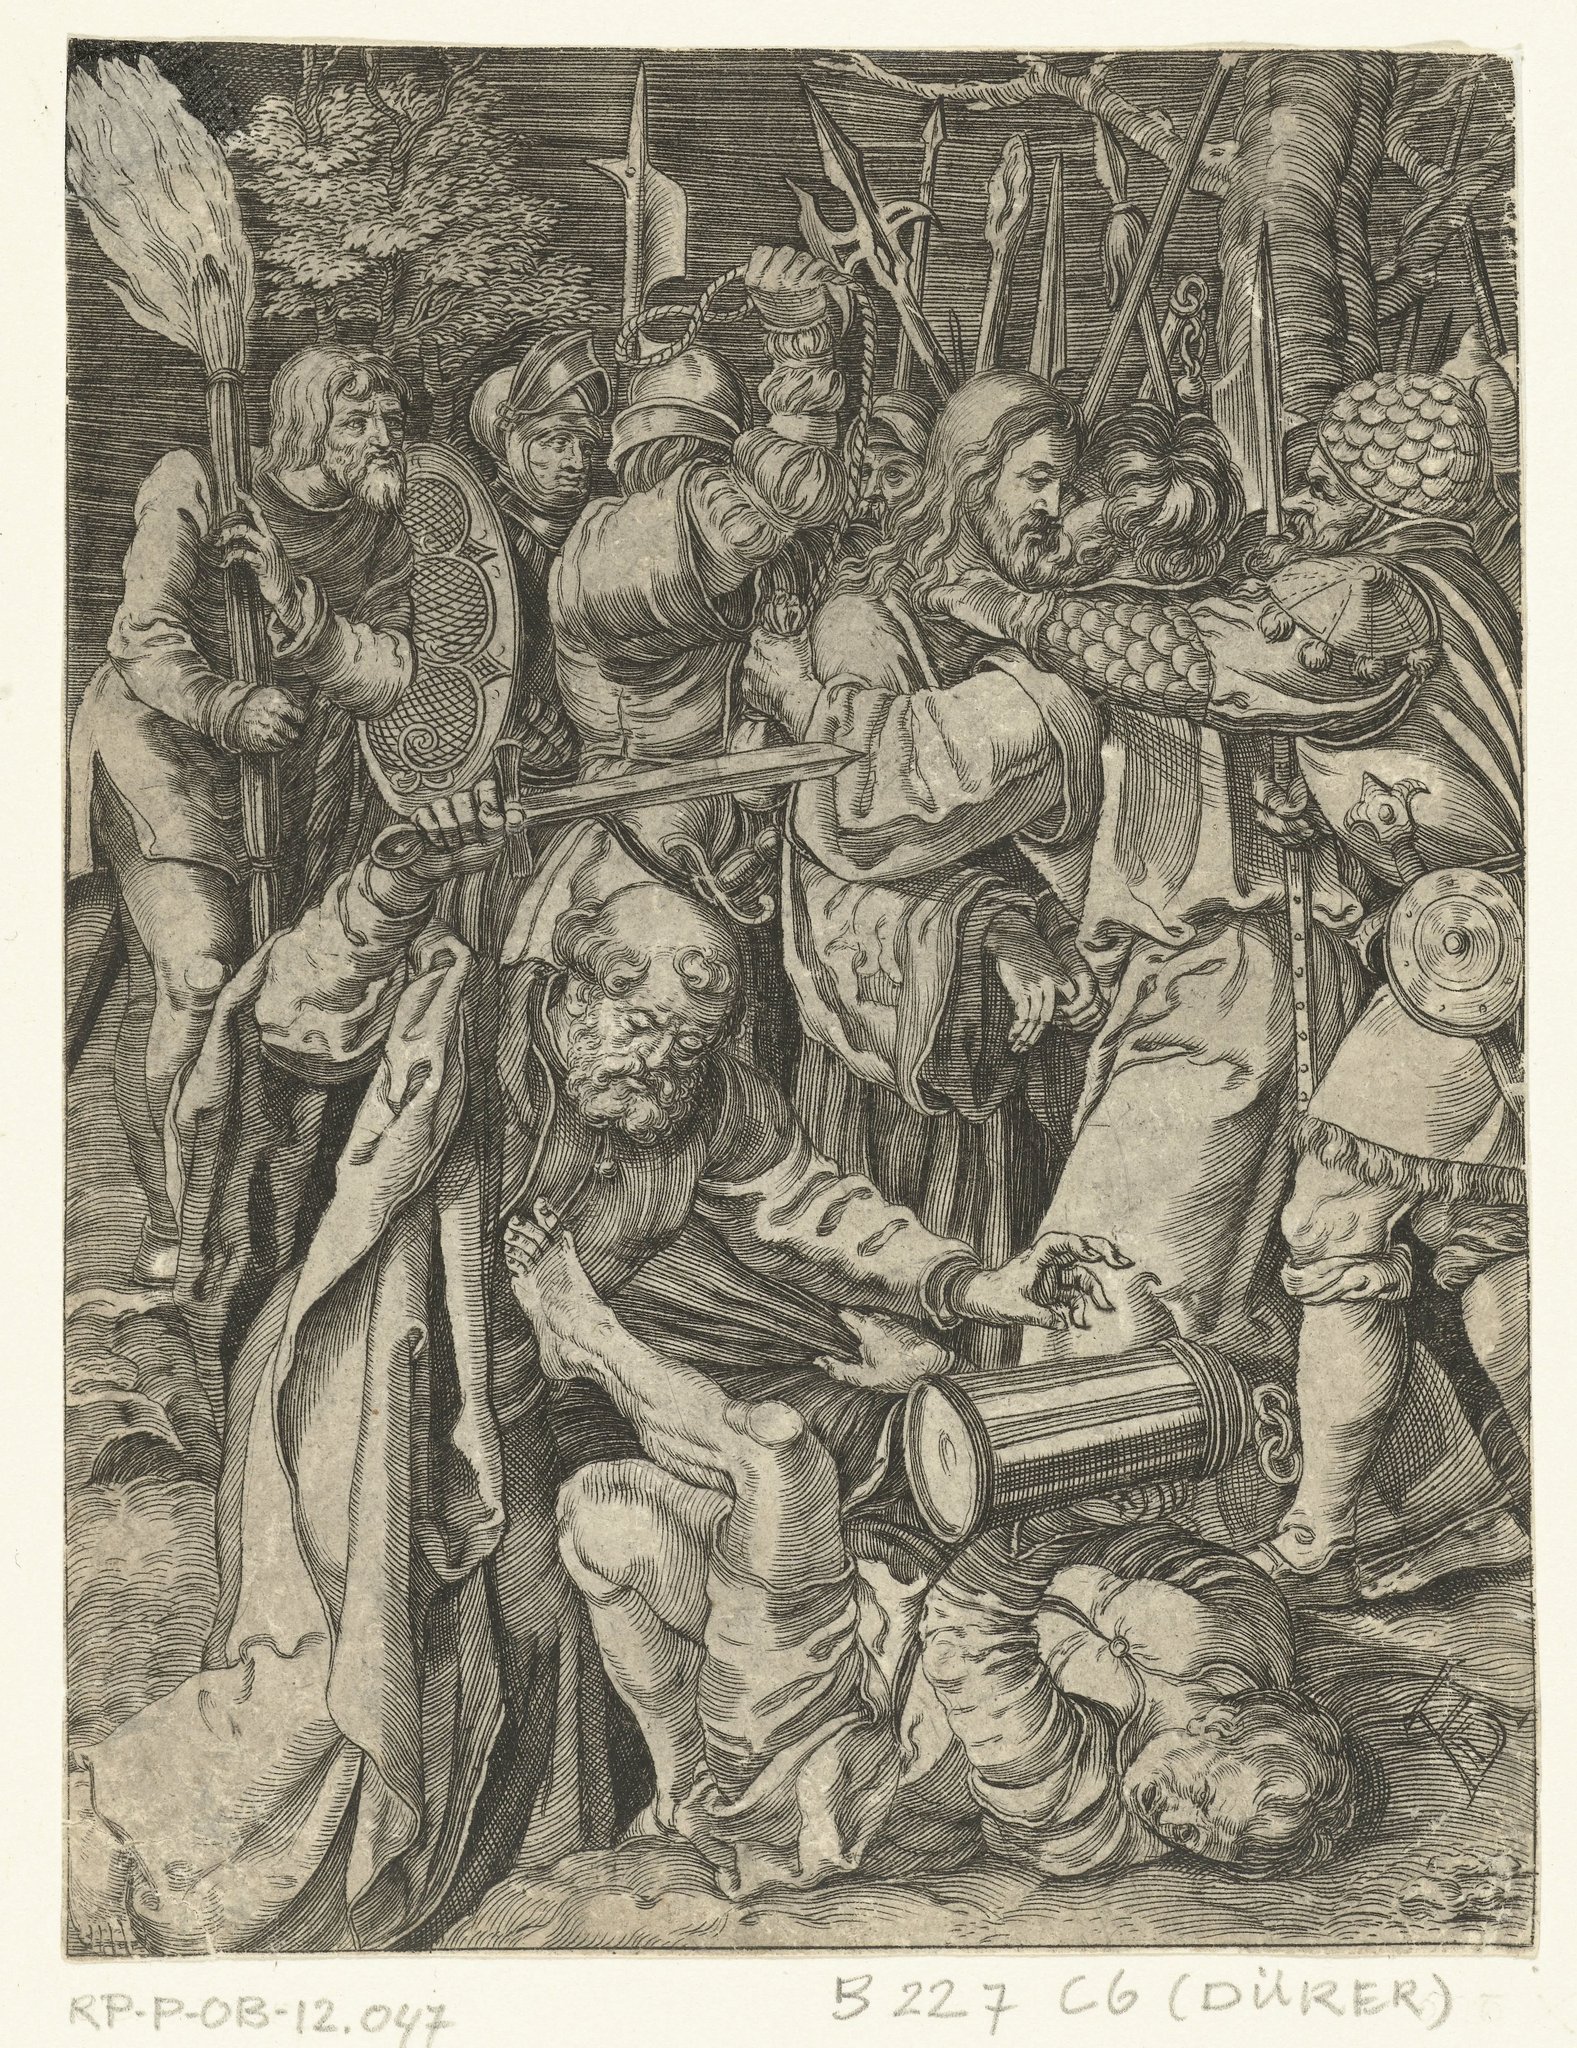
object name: print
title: Passie van Christus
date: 1510-1699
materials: paper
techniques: engraving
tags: the episode of the last supper, christ's arrest, trial, and torture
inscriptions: collector's mark: Lugt 12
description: Prent naar houtsnede van Albrecht Dürer uit een serie van zevenendertig prenten met als onderwerp het levensverhaal van Christus, bekend als Passie van Christus. Illustratie gebruikt voor: Passio Christi ab Alberto Durer Nurenburgensi effigiata, Abraham van Waesberge (uitgever).